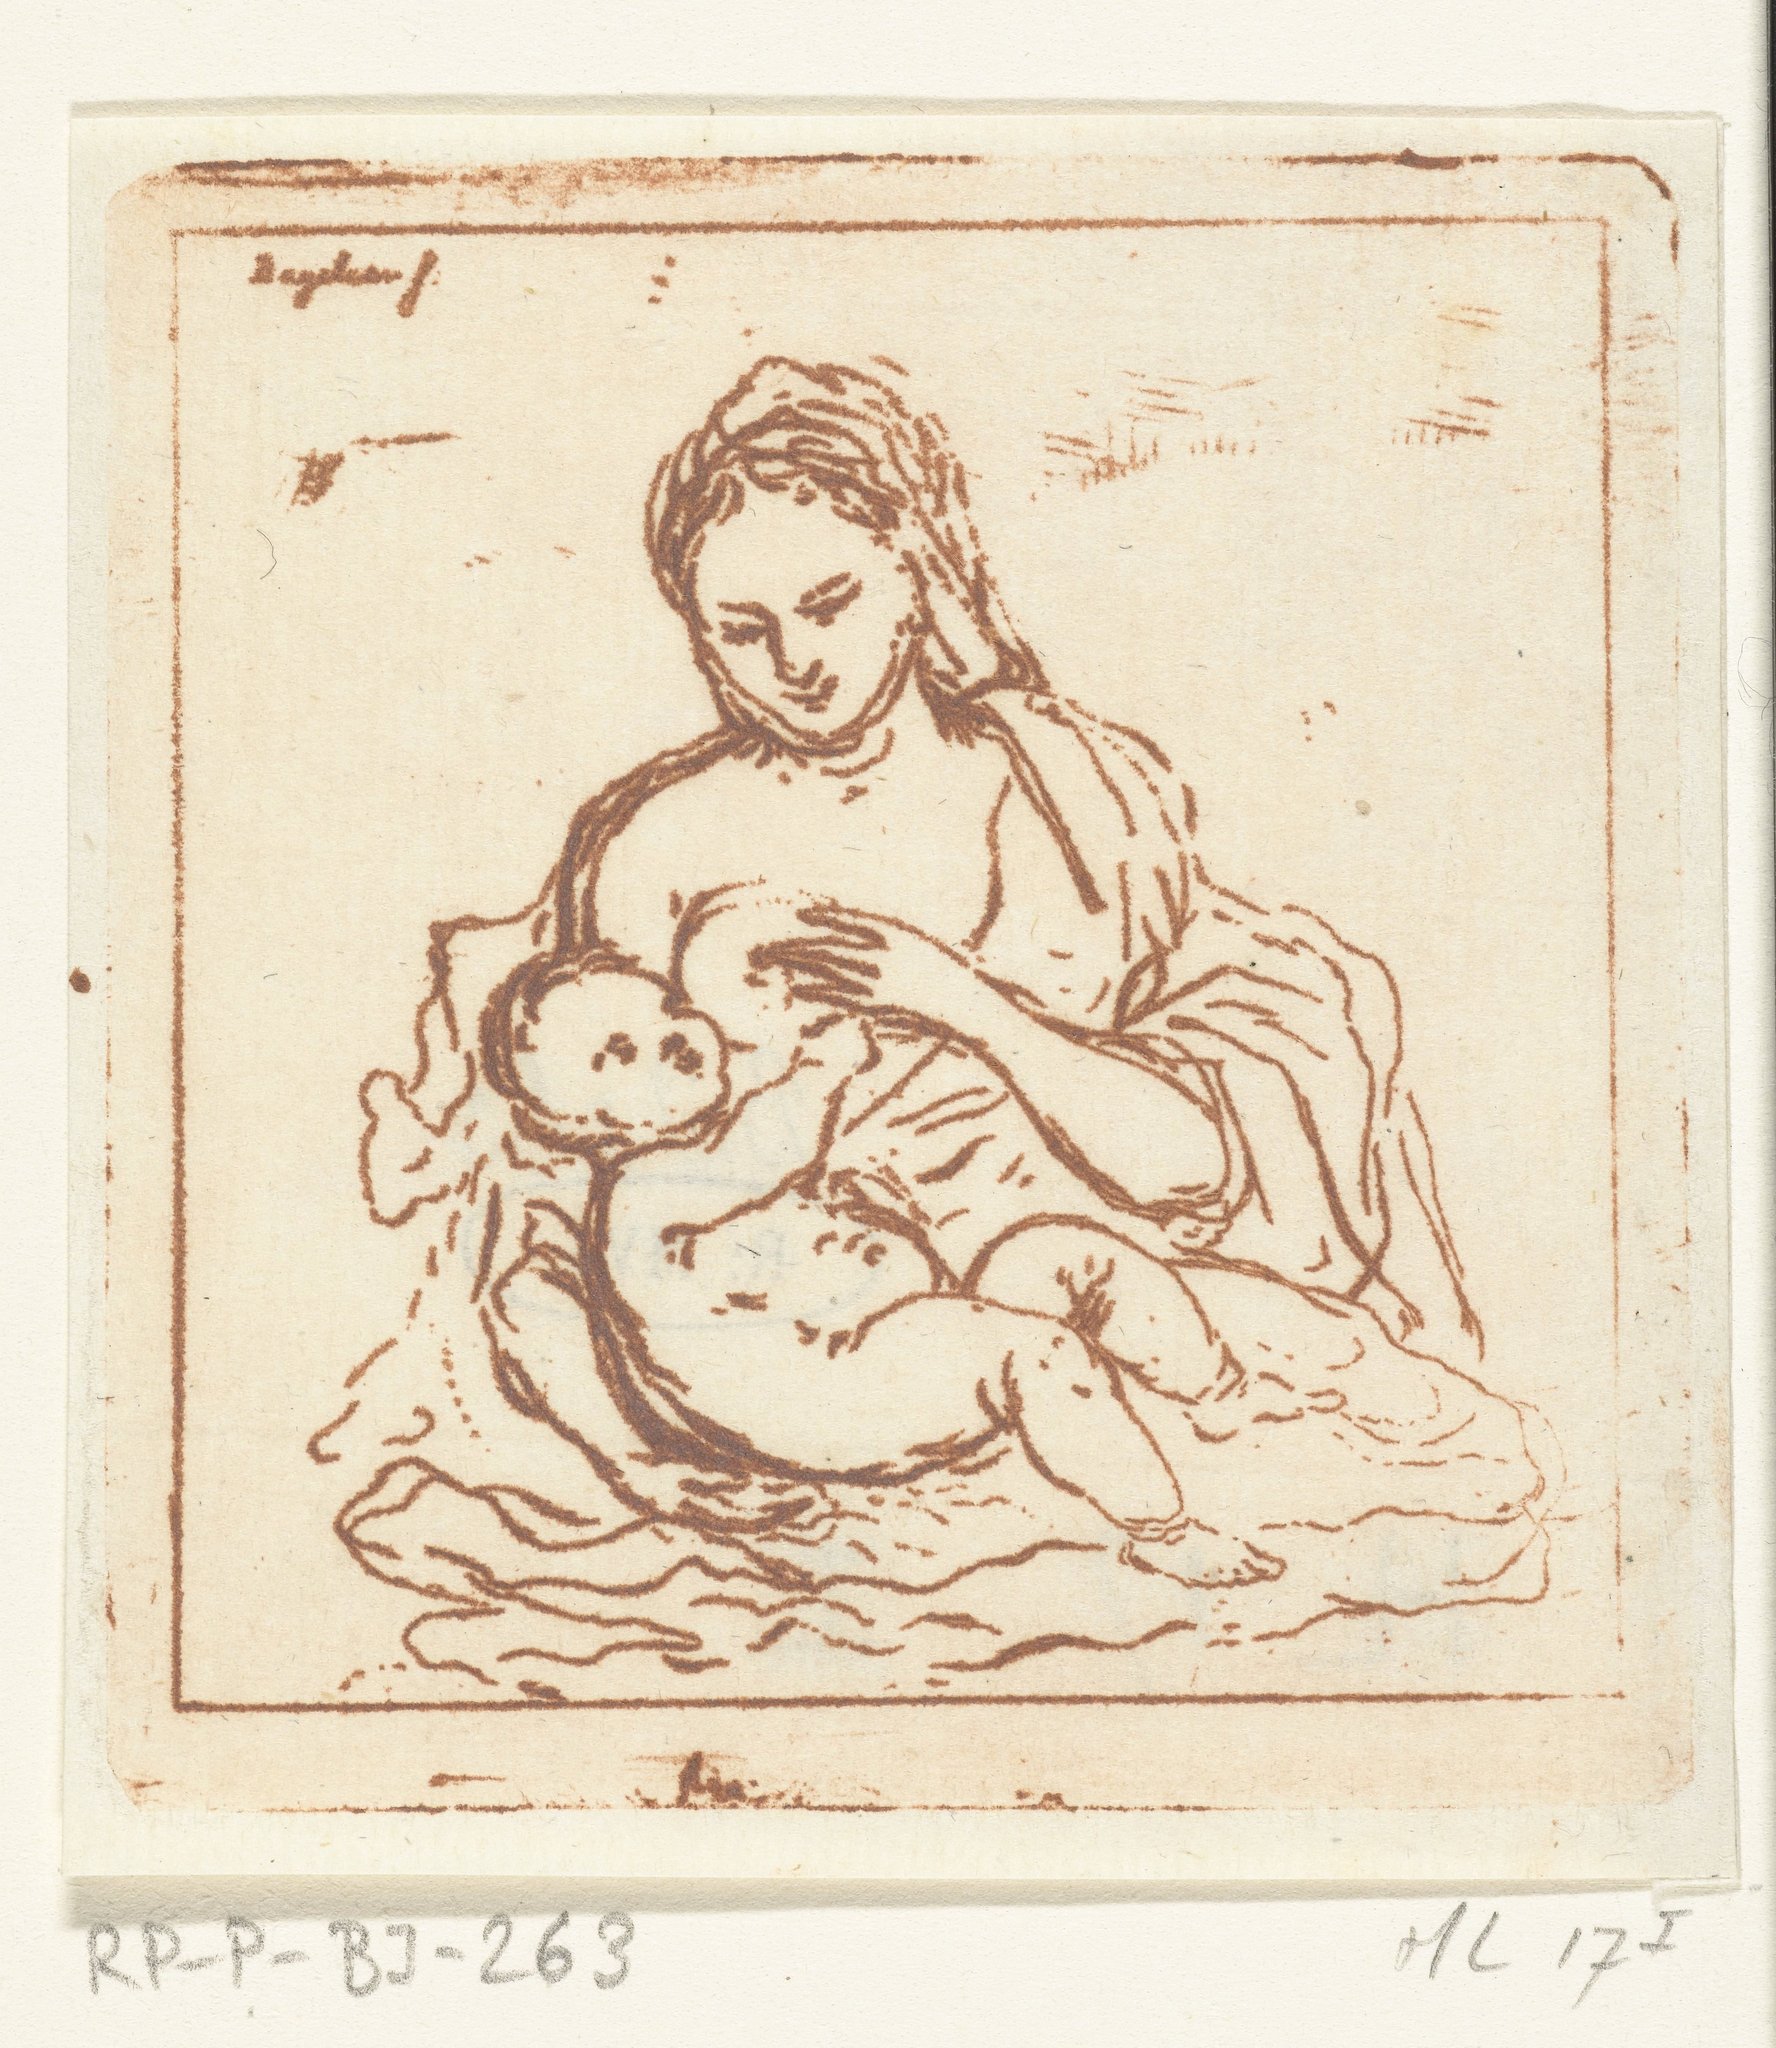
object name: print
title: Maria geeft Christus de borst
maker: ernst willem jan bagelaar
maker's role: draughtsman, print maker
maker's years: 1775-1837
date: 1798-1837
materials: paper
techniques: etching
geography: netherlands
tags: christ-child suckling, or beginning to suckle, e.g. mary uncovering her breast ~ madonna-representations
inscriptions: collector's mark: Lugt 2228